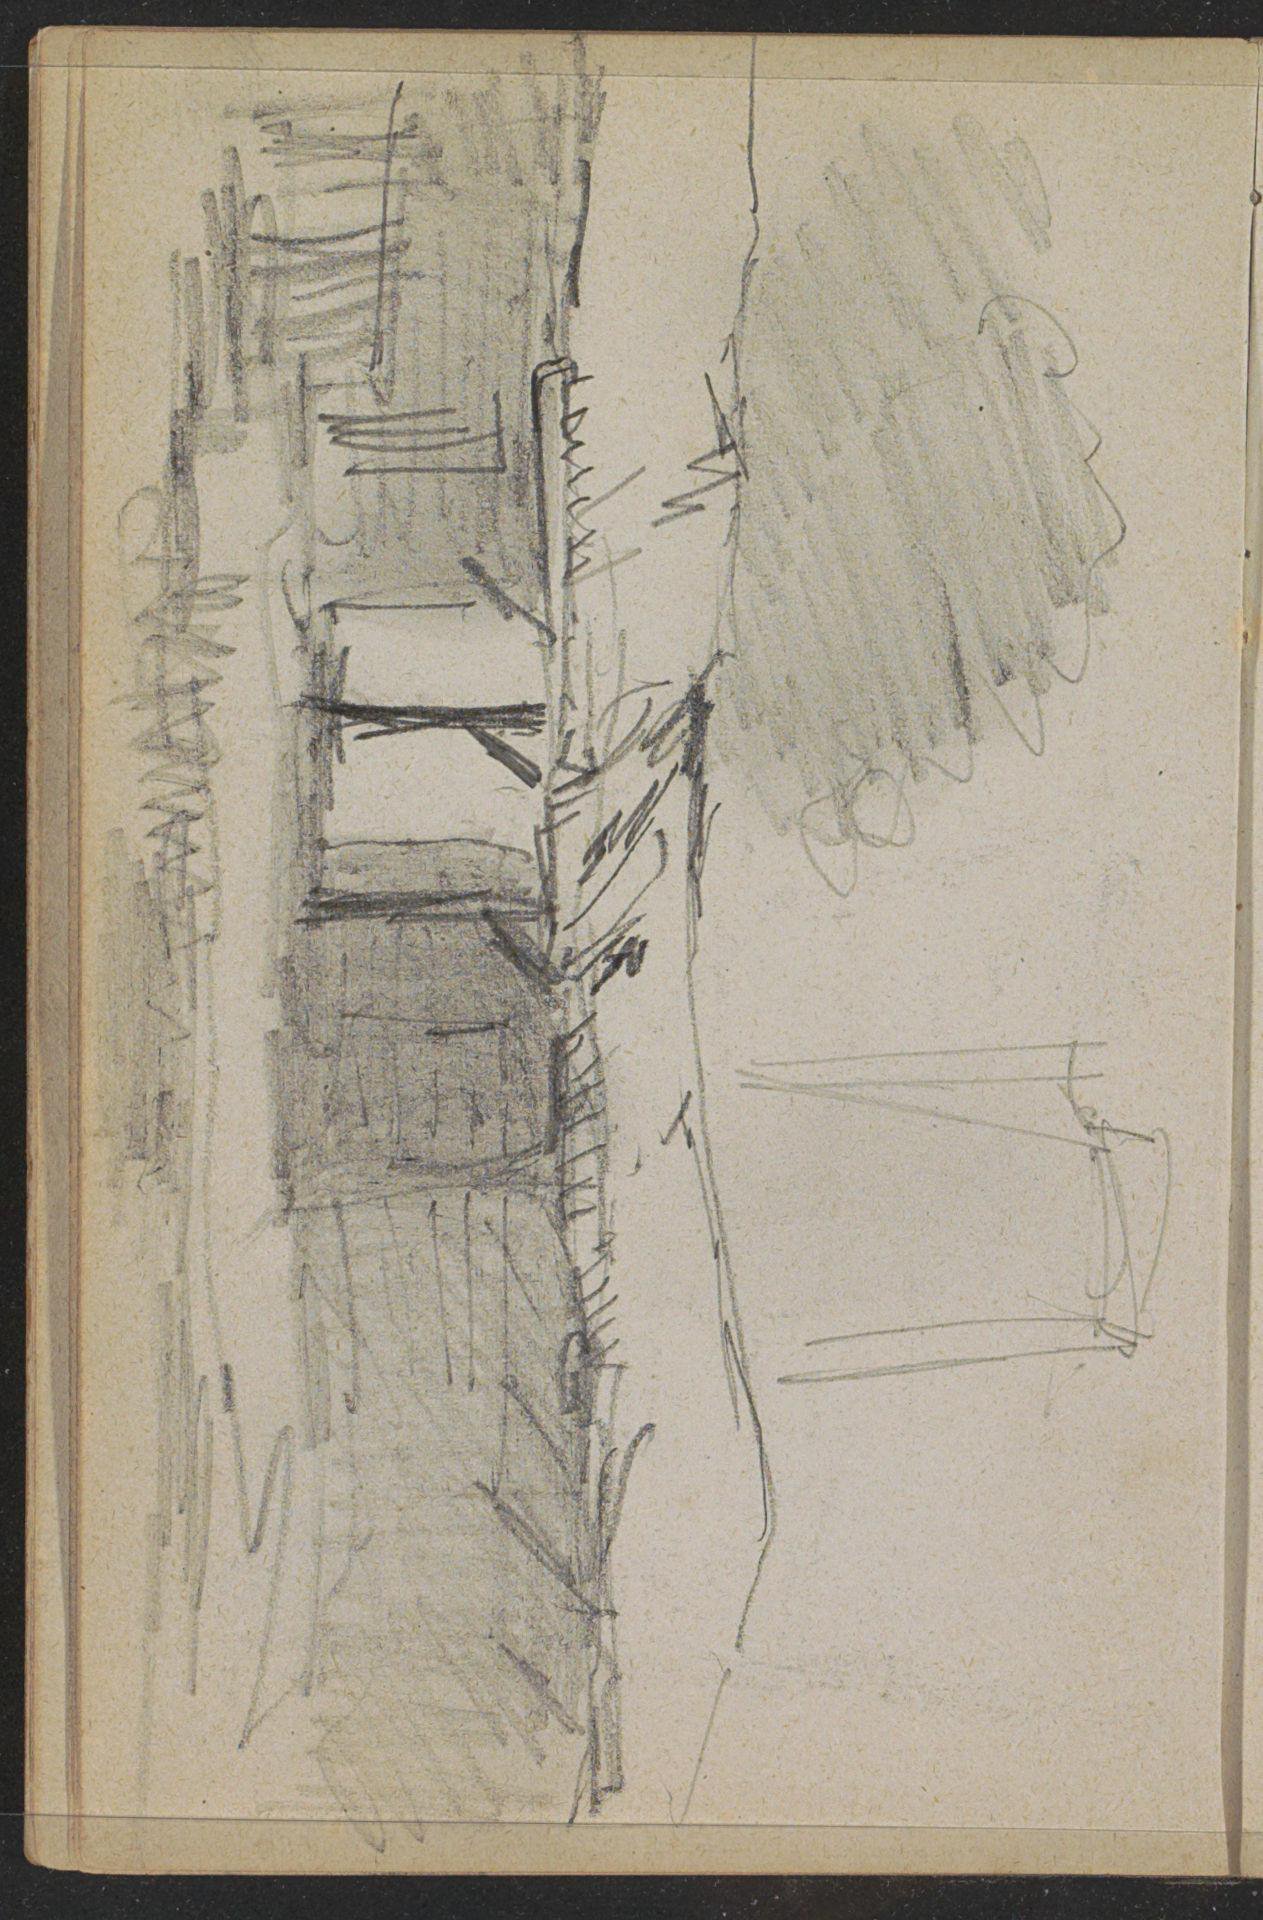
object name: sketchbook leaf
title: Gezicht op bebouwing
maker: adrianus eversen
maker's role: draughtsman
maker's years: 1818-1897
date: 1828-1897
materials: paper, pencil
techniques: stumping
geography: netherlands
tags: windmill in landscape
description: Vooraan laagbouw. Op de achtergrond een molen. Blad 9 verso uit een schetsboek met 58 bladen.